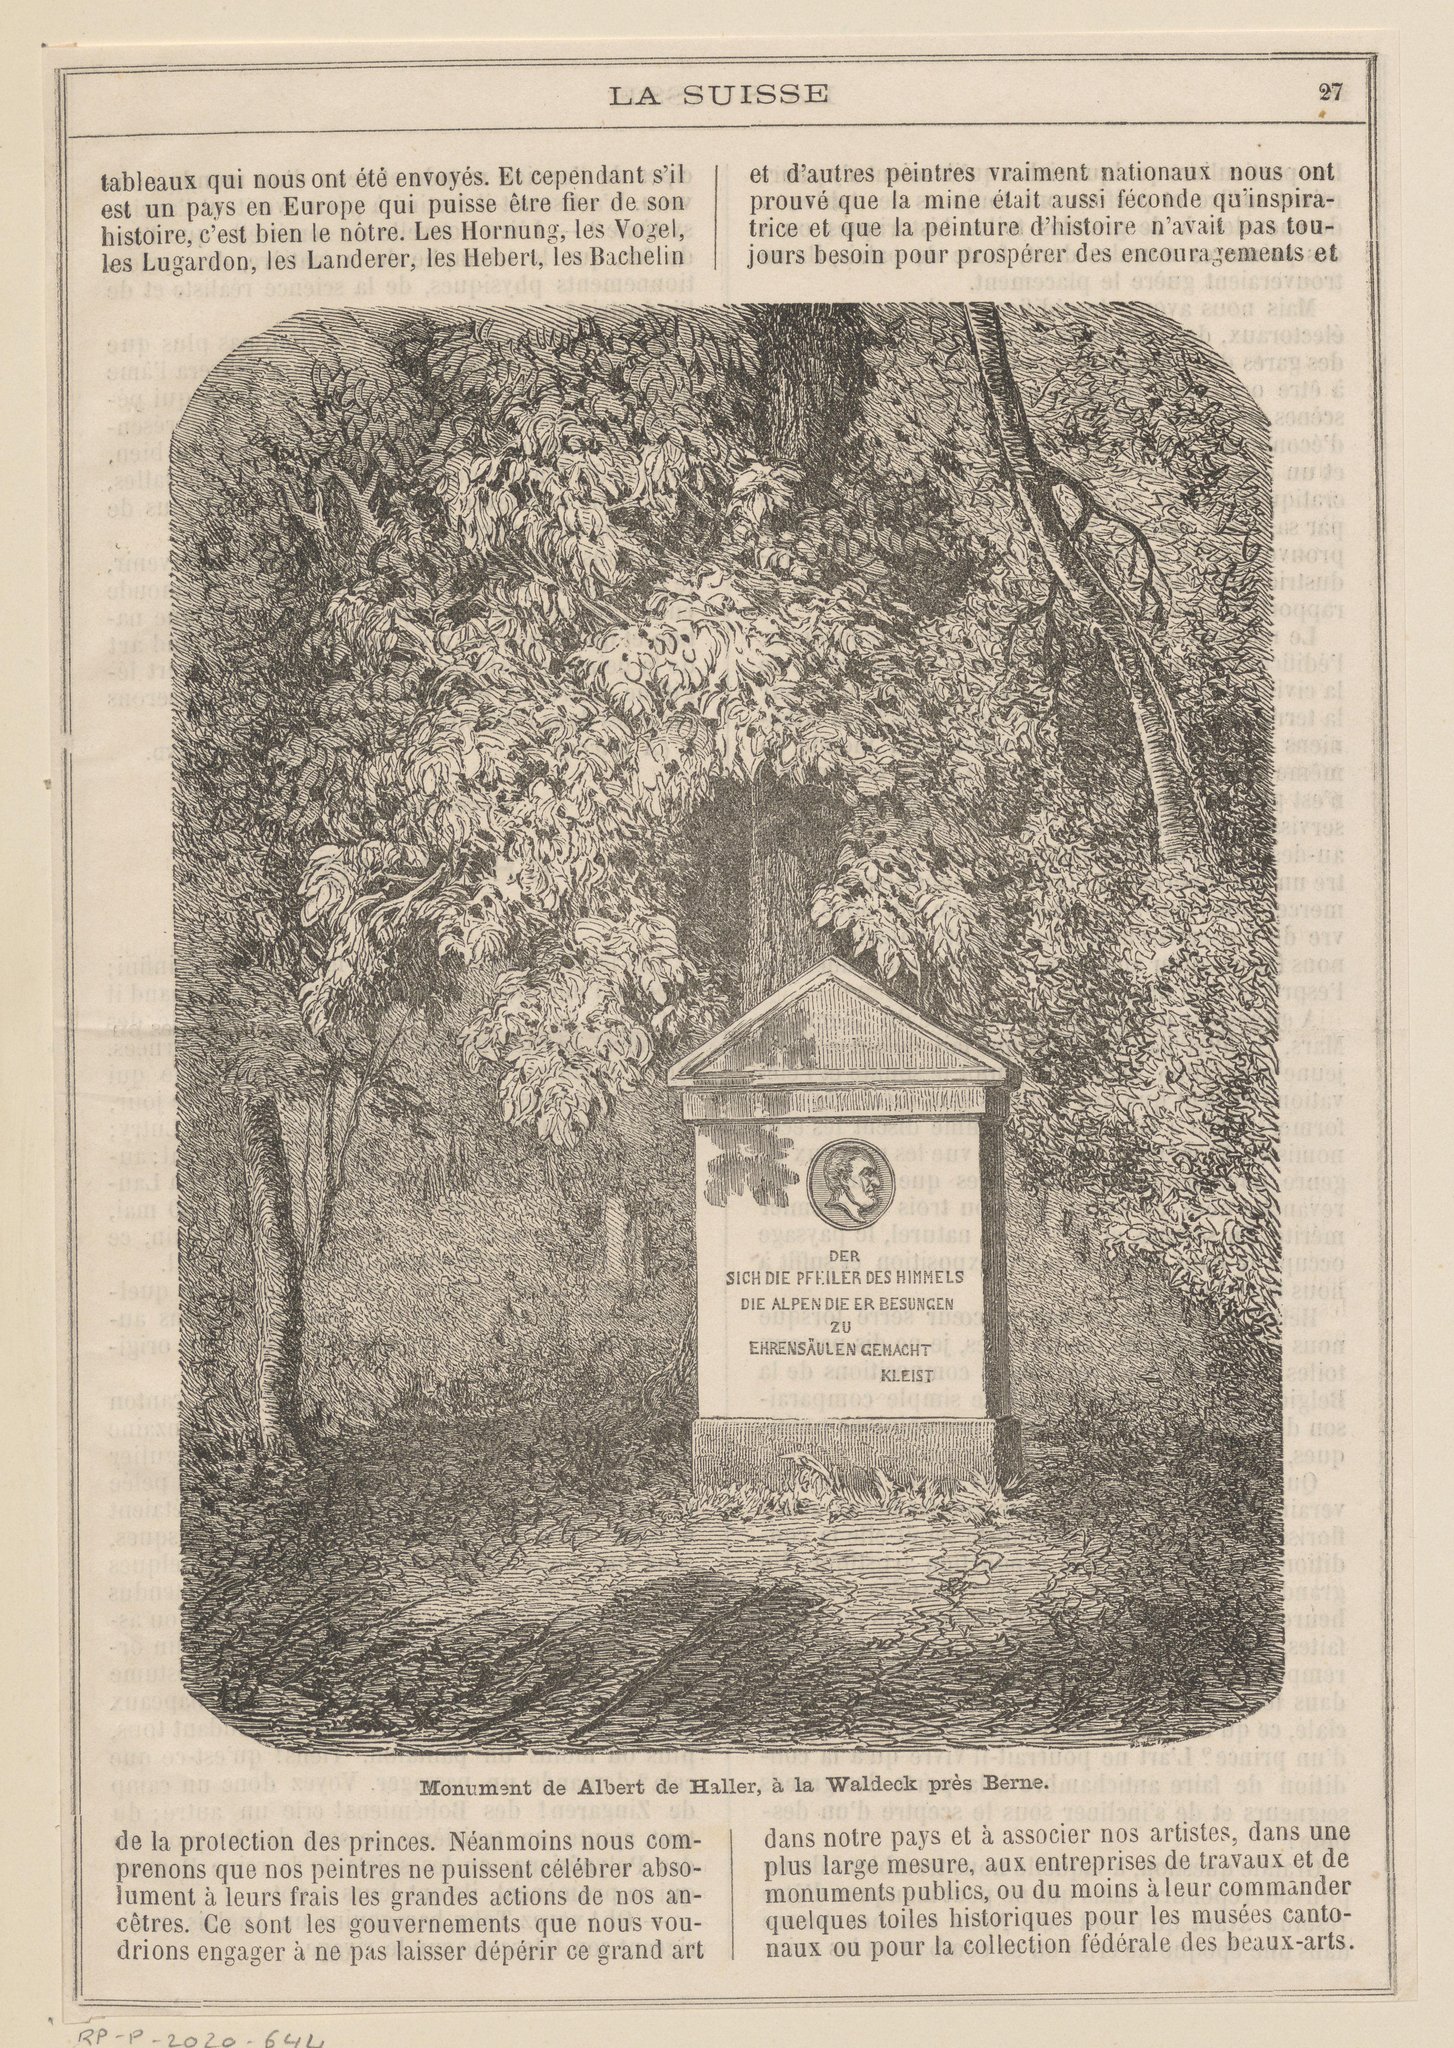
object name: print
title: Monument ter nagedachtenis van Albrecht von Haller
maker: Anonymous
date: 1850-1899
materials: paper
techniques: letterpress printing, engraving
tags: physicist, forest, wood, monument, statue